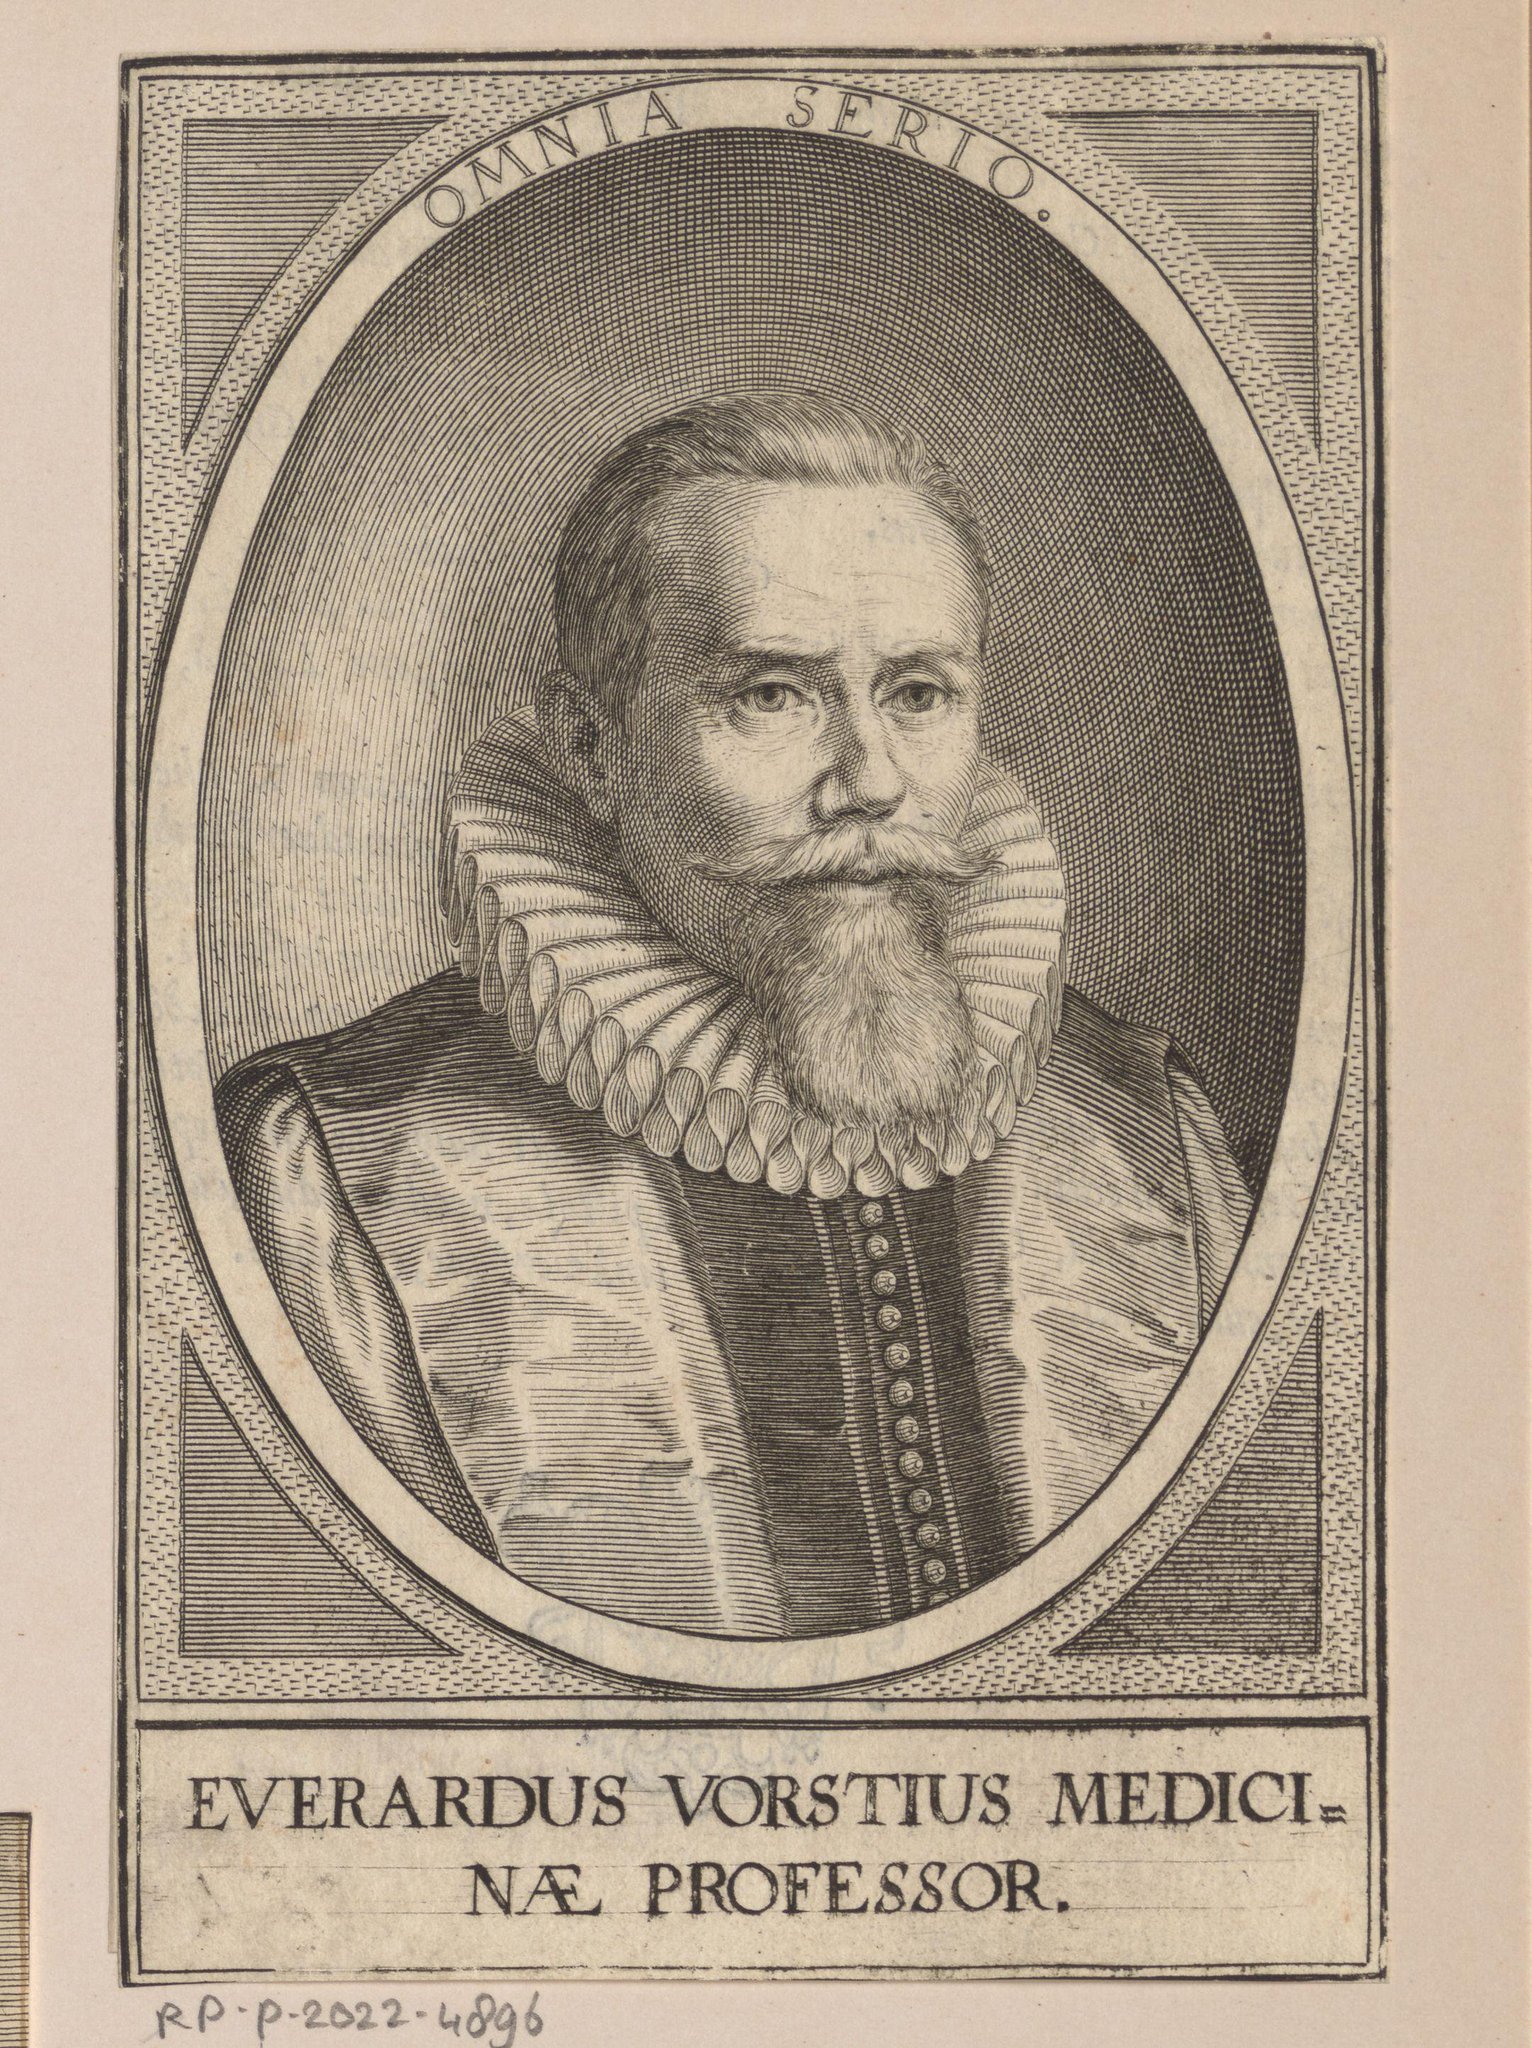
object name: print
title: Portret van Aelius Everardus Vorstius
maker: willem isaacsz. van swanenburg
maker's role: print maker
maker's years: 1580-1612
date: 1613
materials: paper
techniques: engraving, letterpress printing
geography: leiden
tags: scholar, philosopher, historical persons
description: Prent uit: Illustris Academia Lugd-Batava: id est virorum clarissimorum icones, elogia. Leiden: Andries Clouck, 1613.